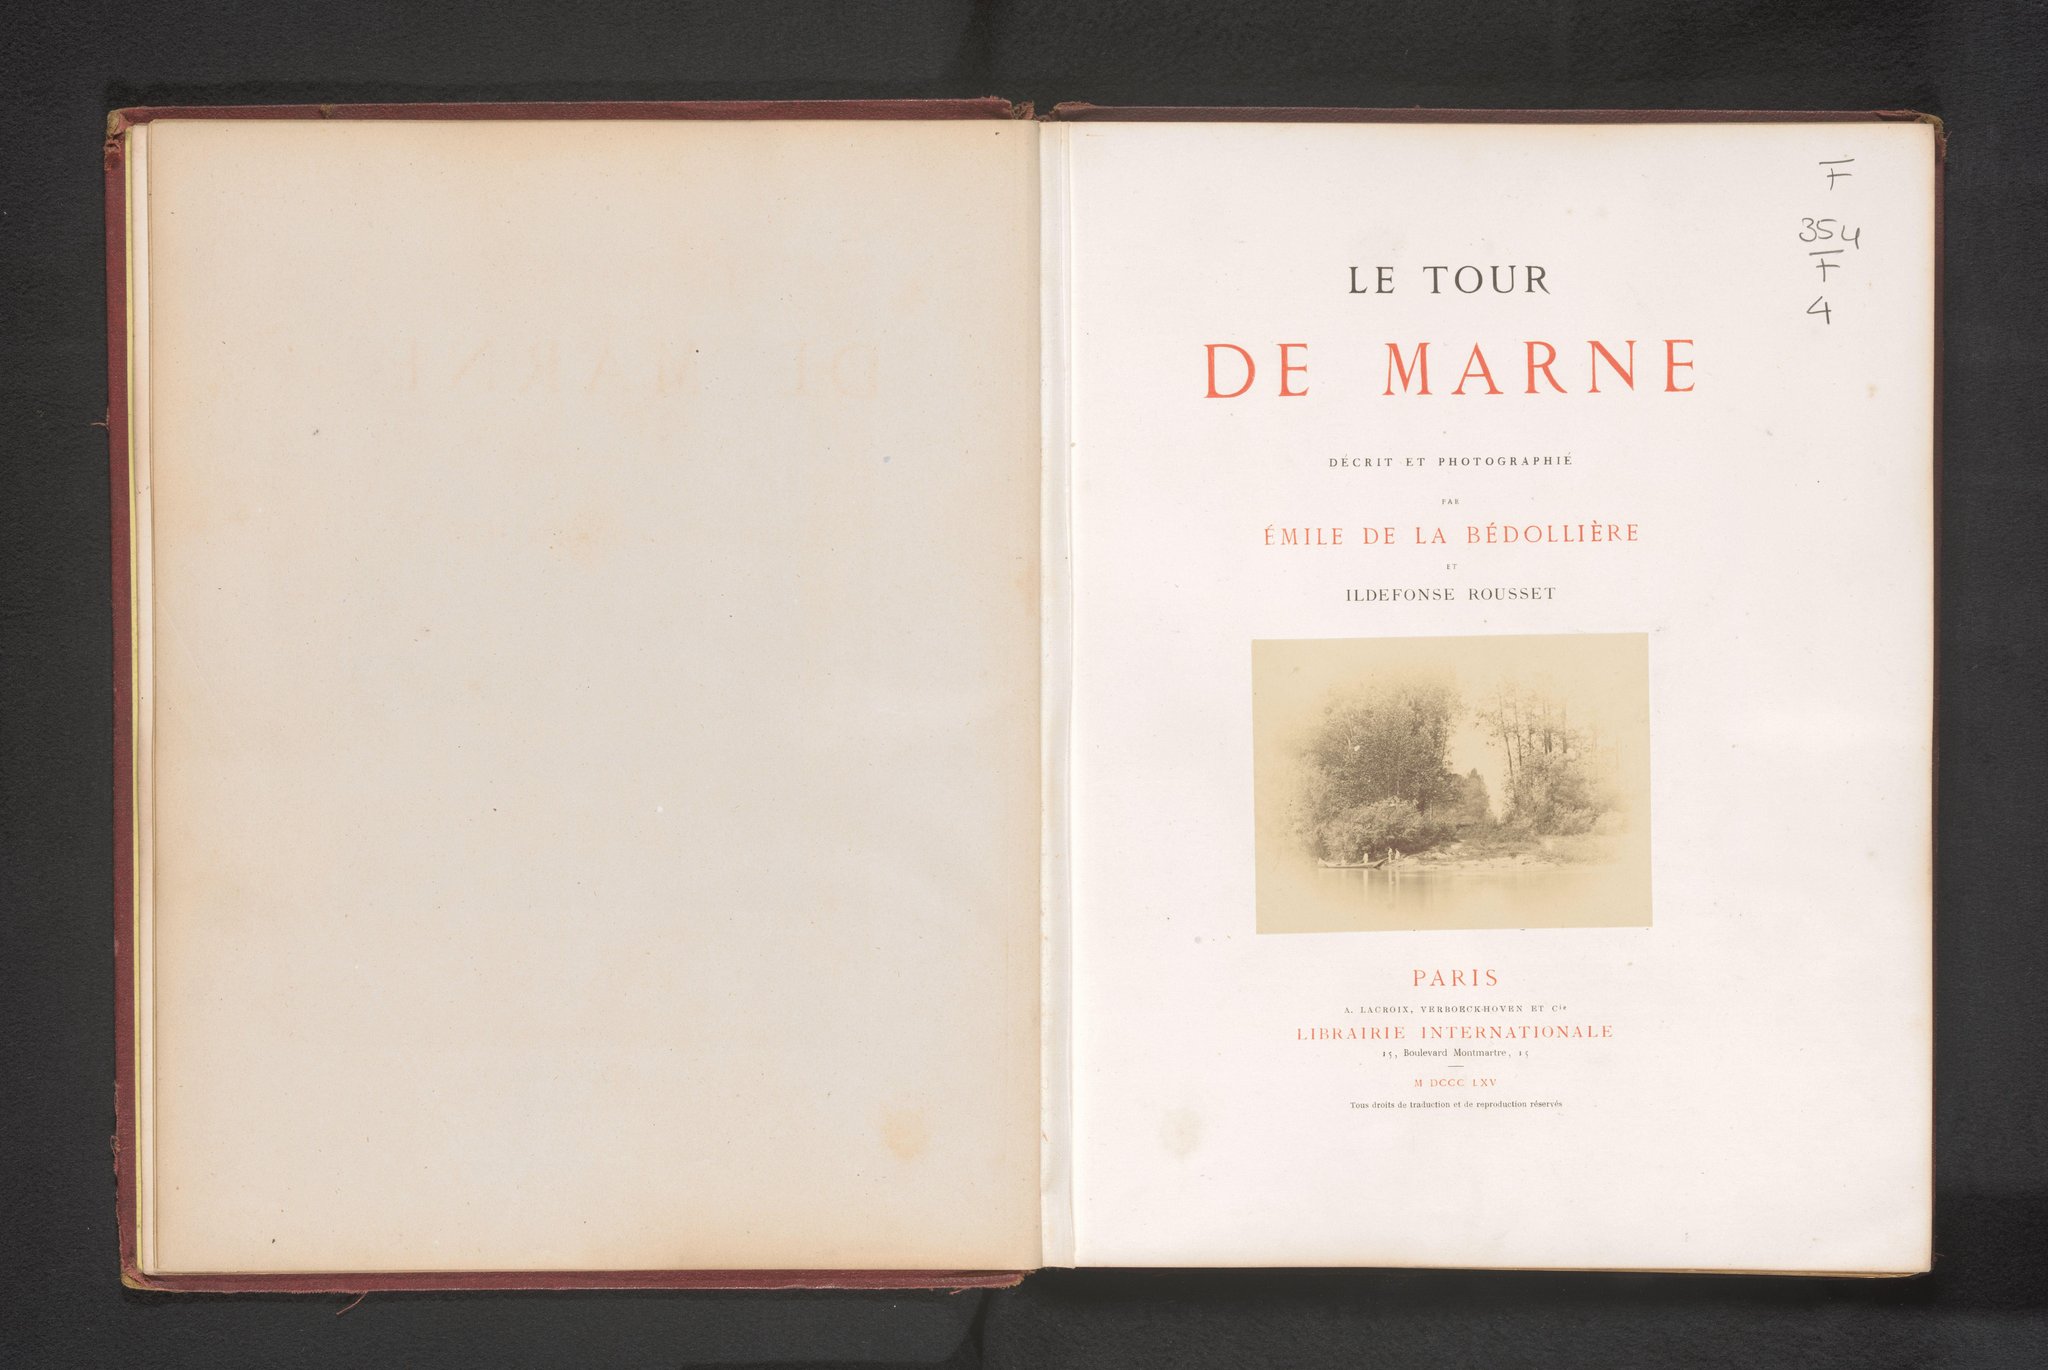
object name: book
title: Le tour de Marne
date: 1865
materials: cardboard, linen, paper, photographic support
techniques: albumen print, lithograph, printing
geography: paris